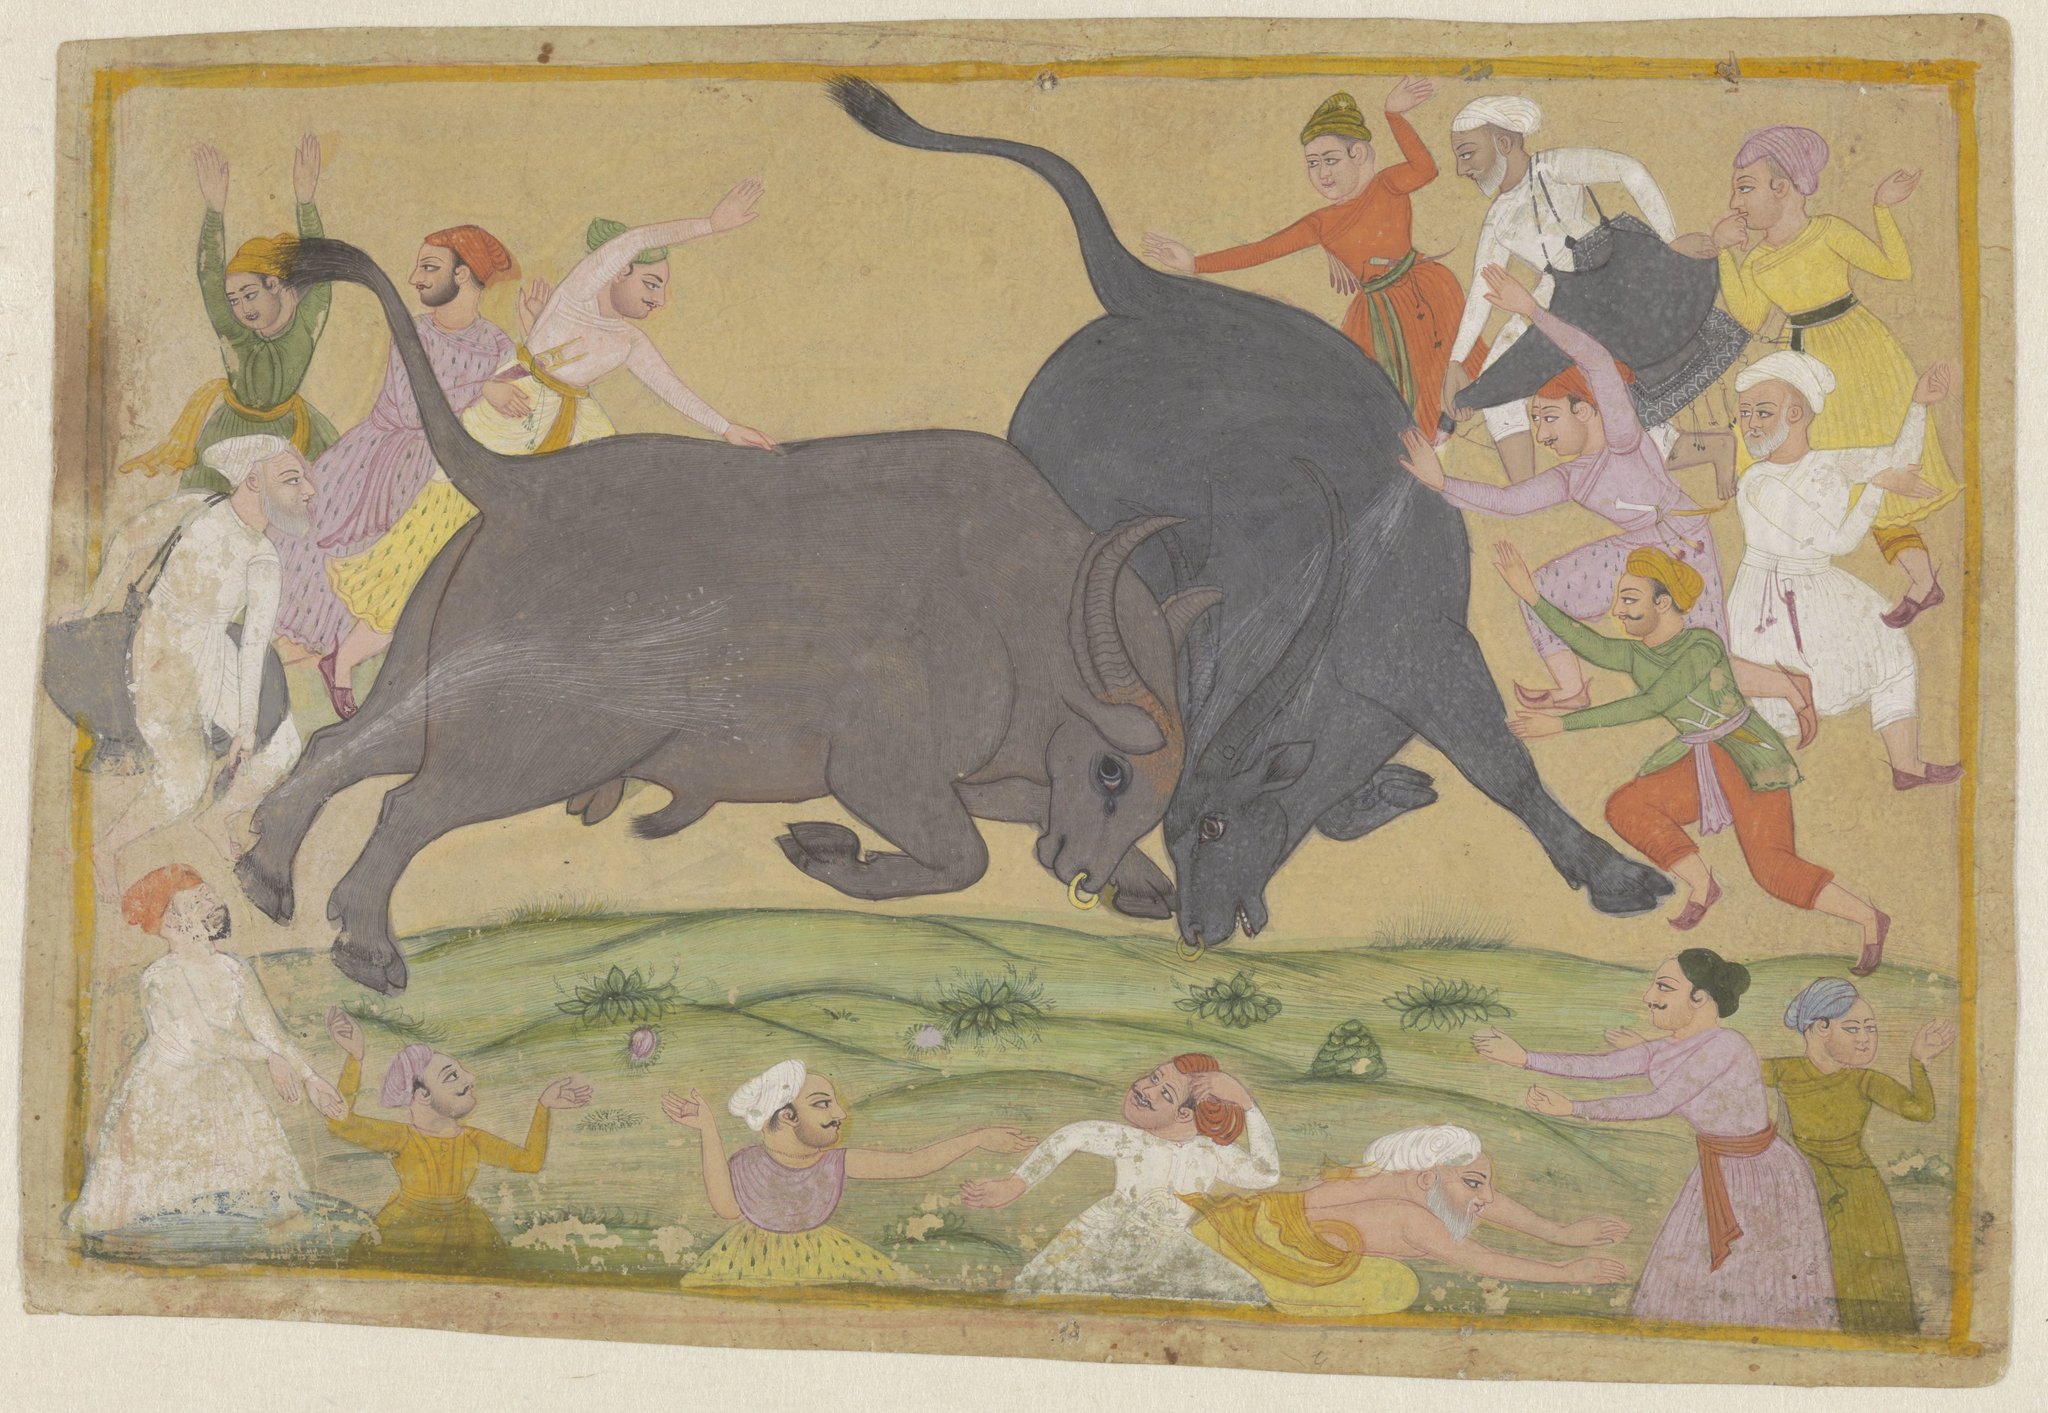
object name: indian miniature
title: Waterbuffelgevecht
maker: Anonymous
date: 1775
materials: paper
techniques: brush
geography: bundi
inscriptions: inscription: ‘.’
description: In een heuvelachtig landschap zijn twee grote waterbuffels in gevecht met elkaar, de omstanders proberen de dieren letterlijk af te koelen met water uit hun waterzakken en maken veel misbaar, een oude man vlucht weg in paniek. De voorstelling is afgebiesd met een geel randje en losse lijntjes, aan de randen en kanten lichte beschadigingen.